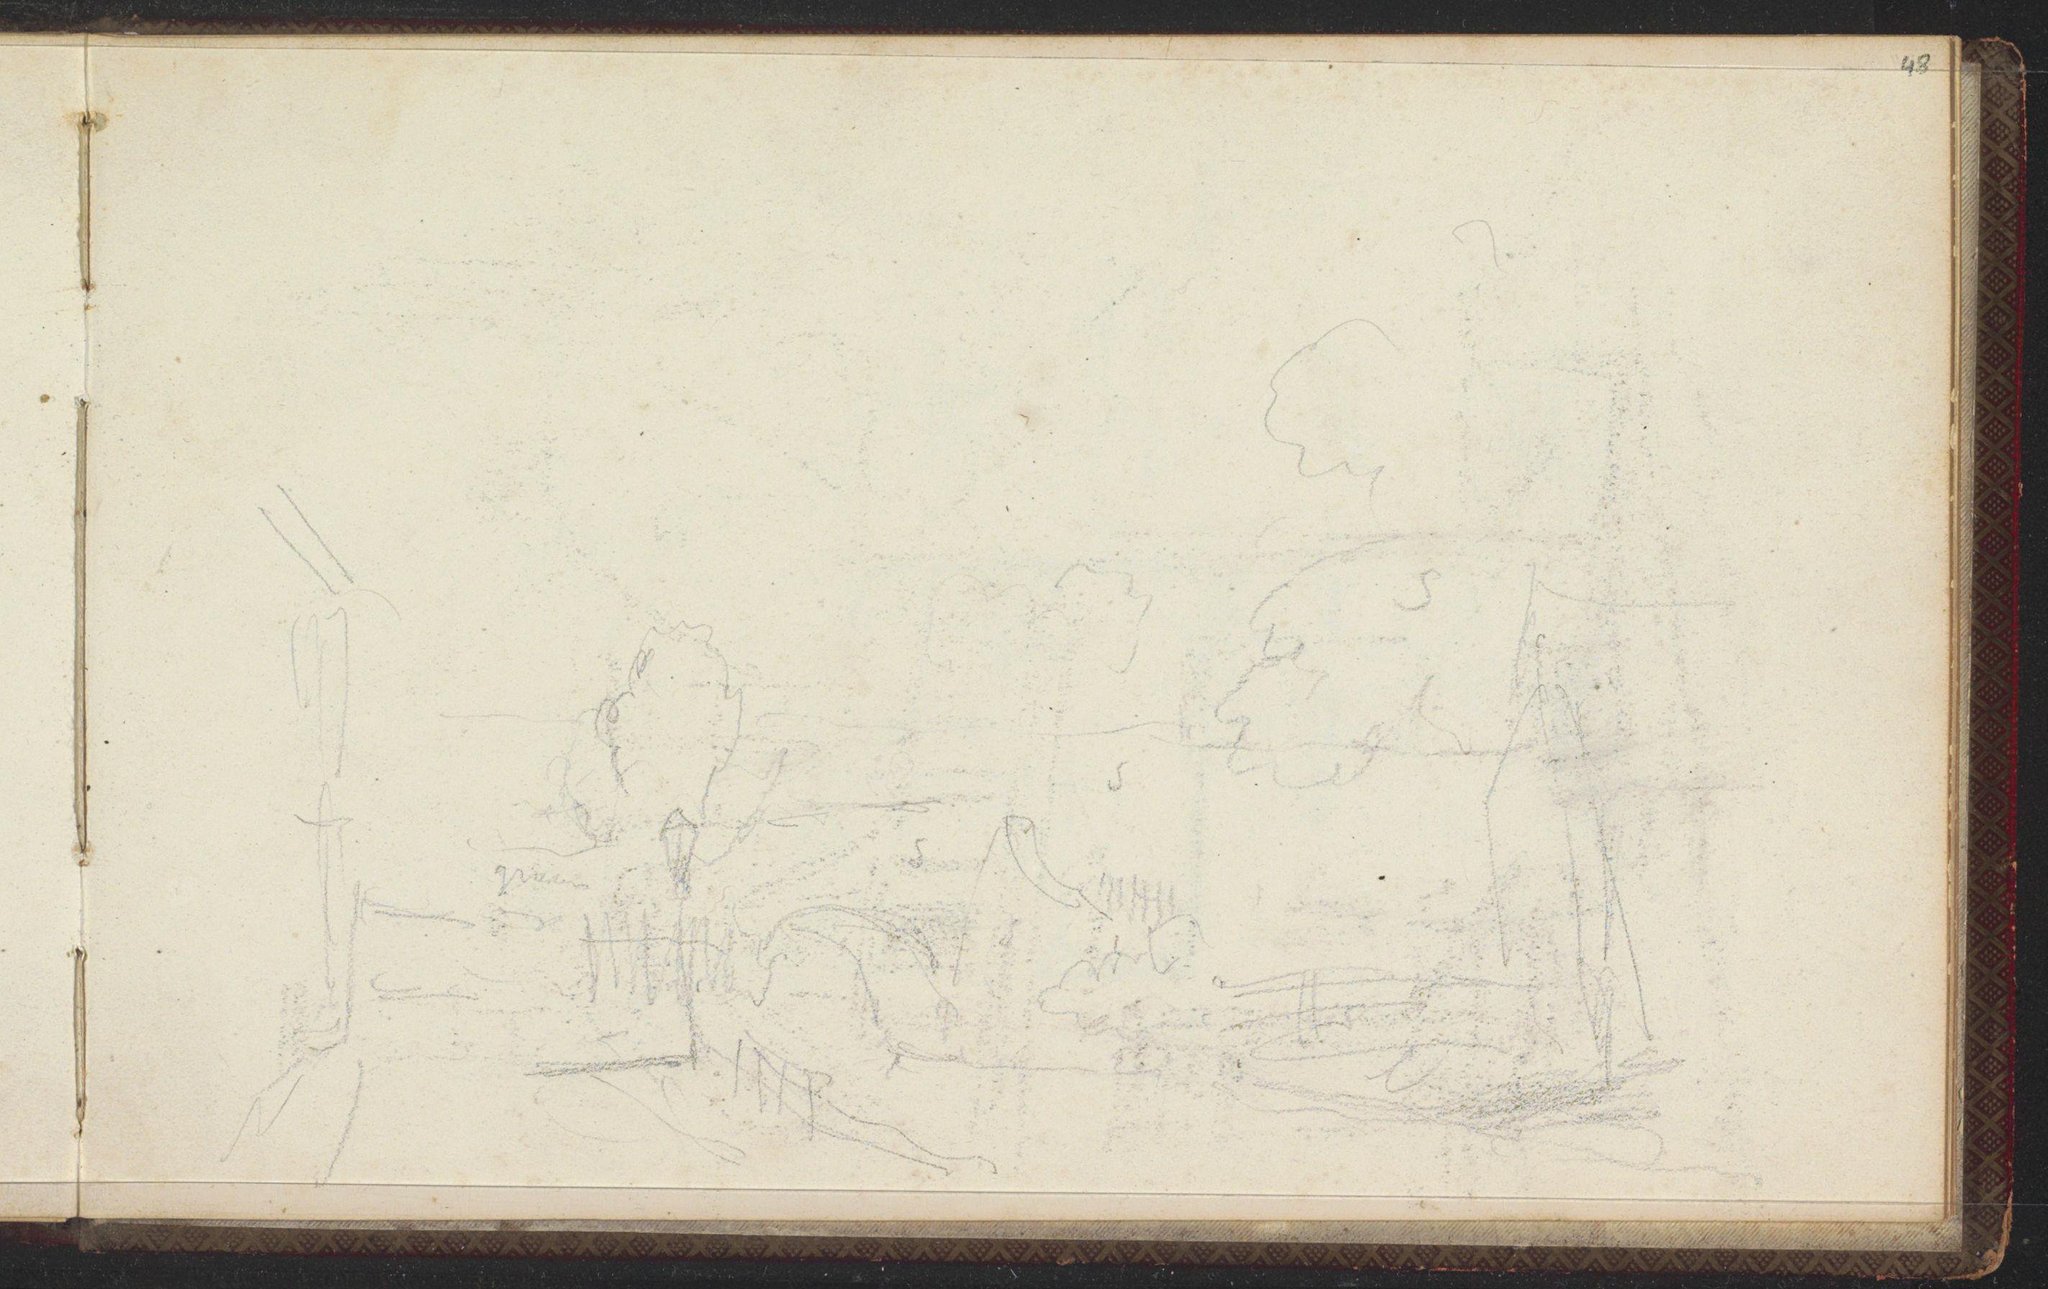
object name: sketchbook leaf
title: Straatlantaarn lang een weg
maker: adrianus eversen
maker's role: draughtsman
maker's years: 1818-1897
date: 1828-1897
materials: paper, pencil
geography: netherlands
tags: road, path, lantern, civic architecture; edifices; dwellings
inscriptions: kleurnotitie, handgeschreven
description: Aan een weg staat een straatlantaarn. Links en rechts een gebouw. Rechts een boom. Blad 48 recto uit een schetsboek met 52 bladen vervaardigd in de omgeving van Kampen, Hattem, Hoorn en Zwolle.